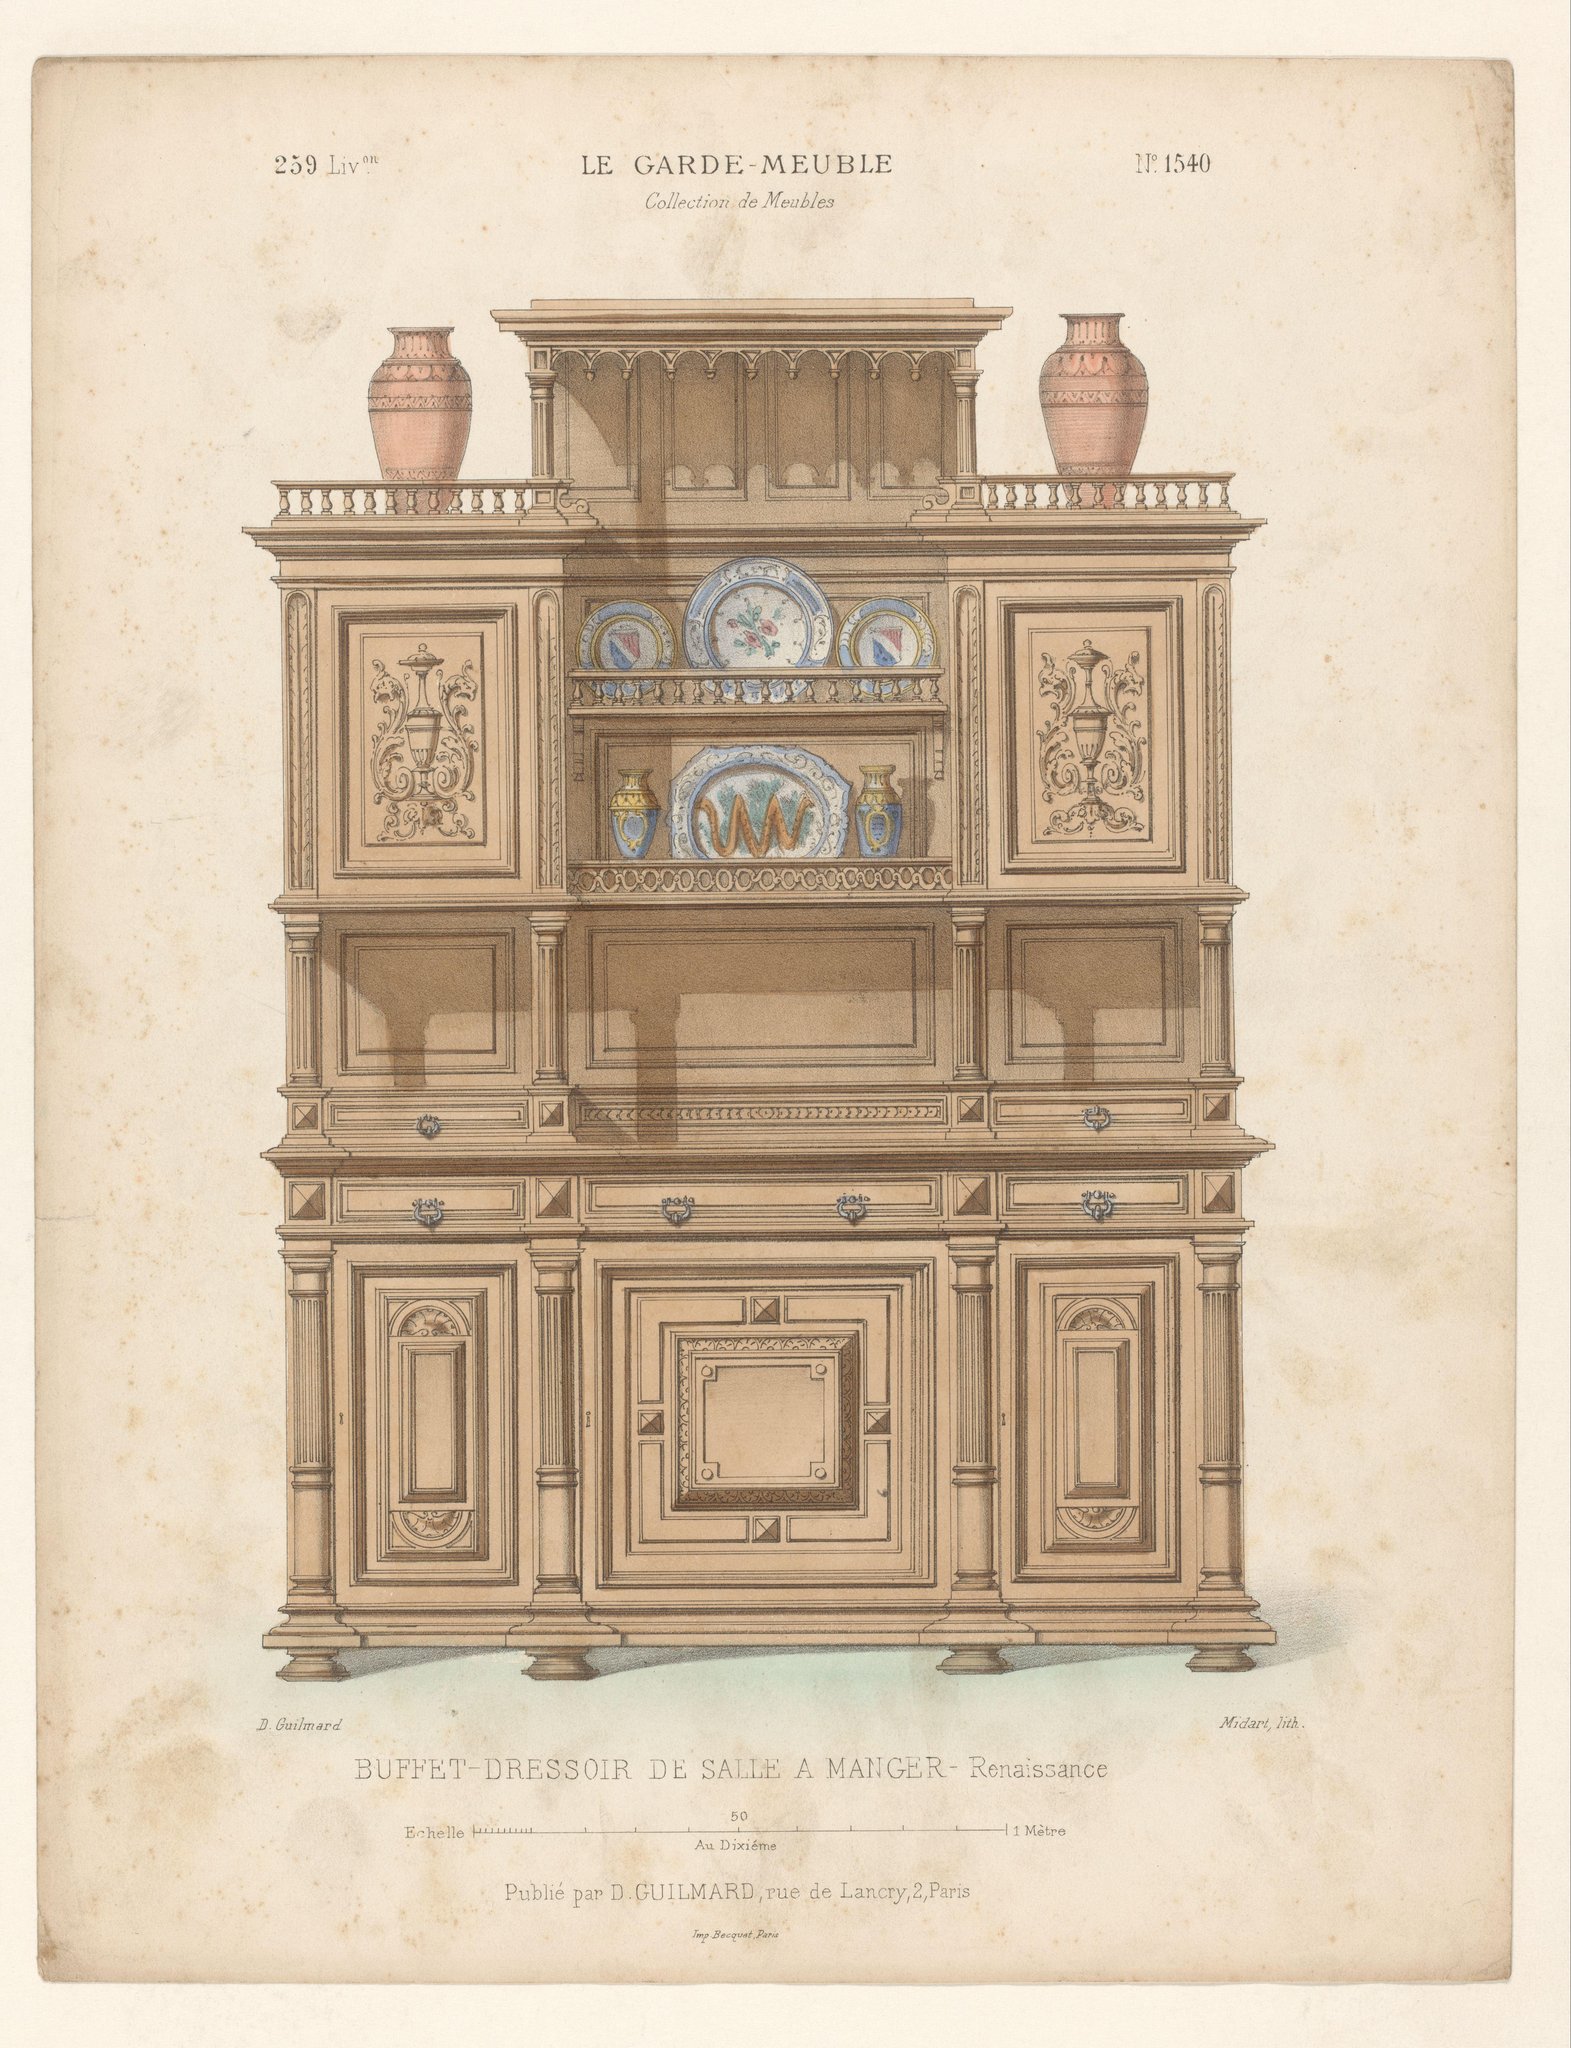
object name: print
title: Buffet-dressoir de salle a manger Renaissance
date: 1839-1885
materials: paper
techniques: hand coloring, lithograph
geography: paris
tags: furniture for storage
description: Ieder Livraison in de serie Le Garde-Meuble bevat negen platen: drie 'sièges' (zitmeubels), drie 'meubles' (diverse meubels zoals tafels en kasten) en drie 'tentures' (gordijnen en draperieën).